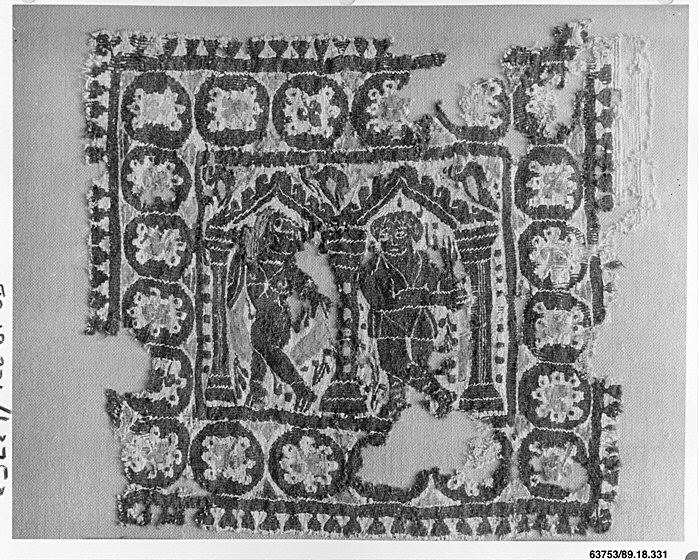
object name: textile fragment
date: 301-400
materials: linen, wool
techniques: weave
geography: egypt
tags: human figures